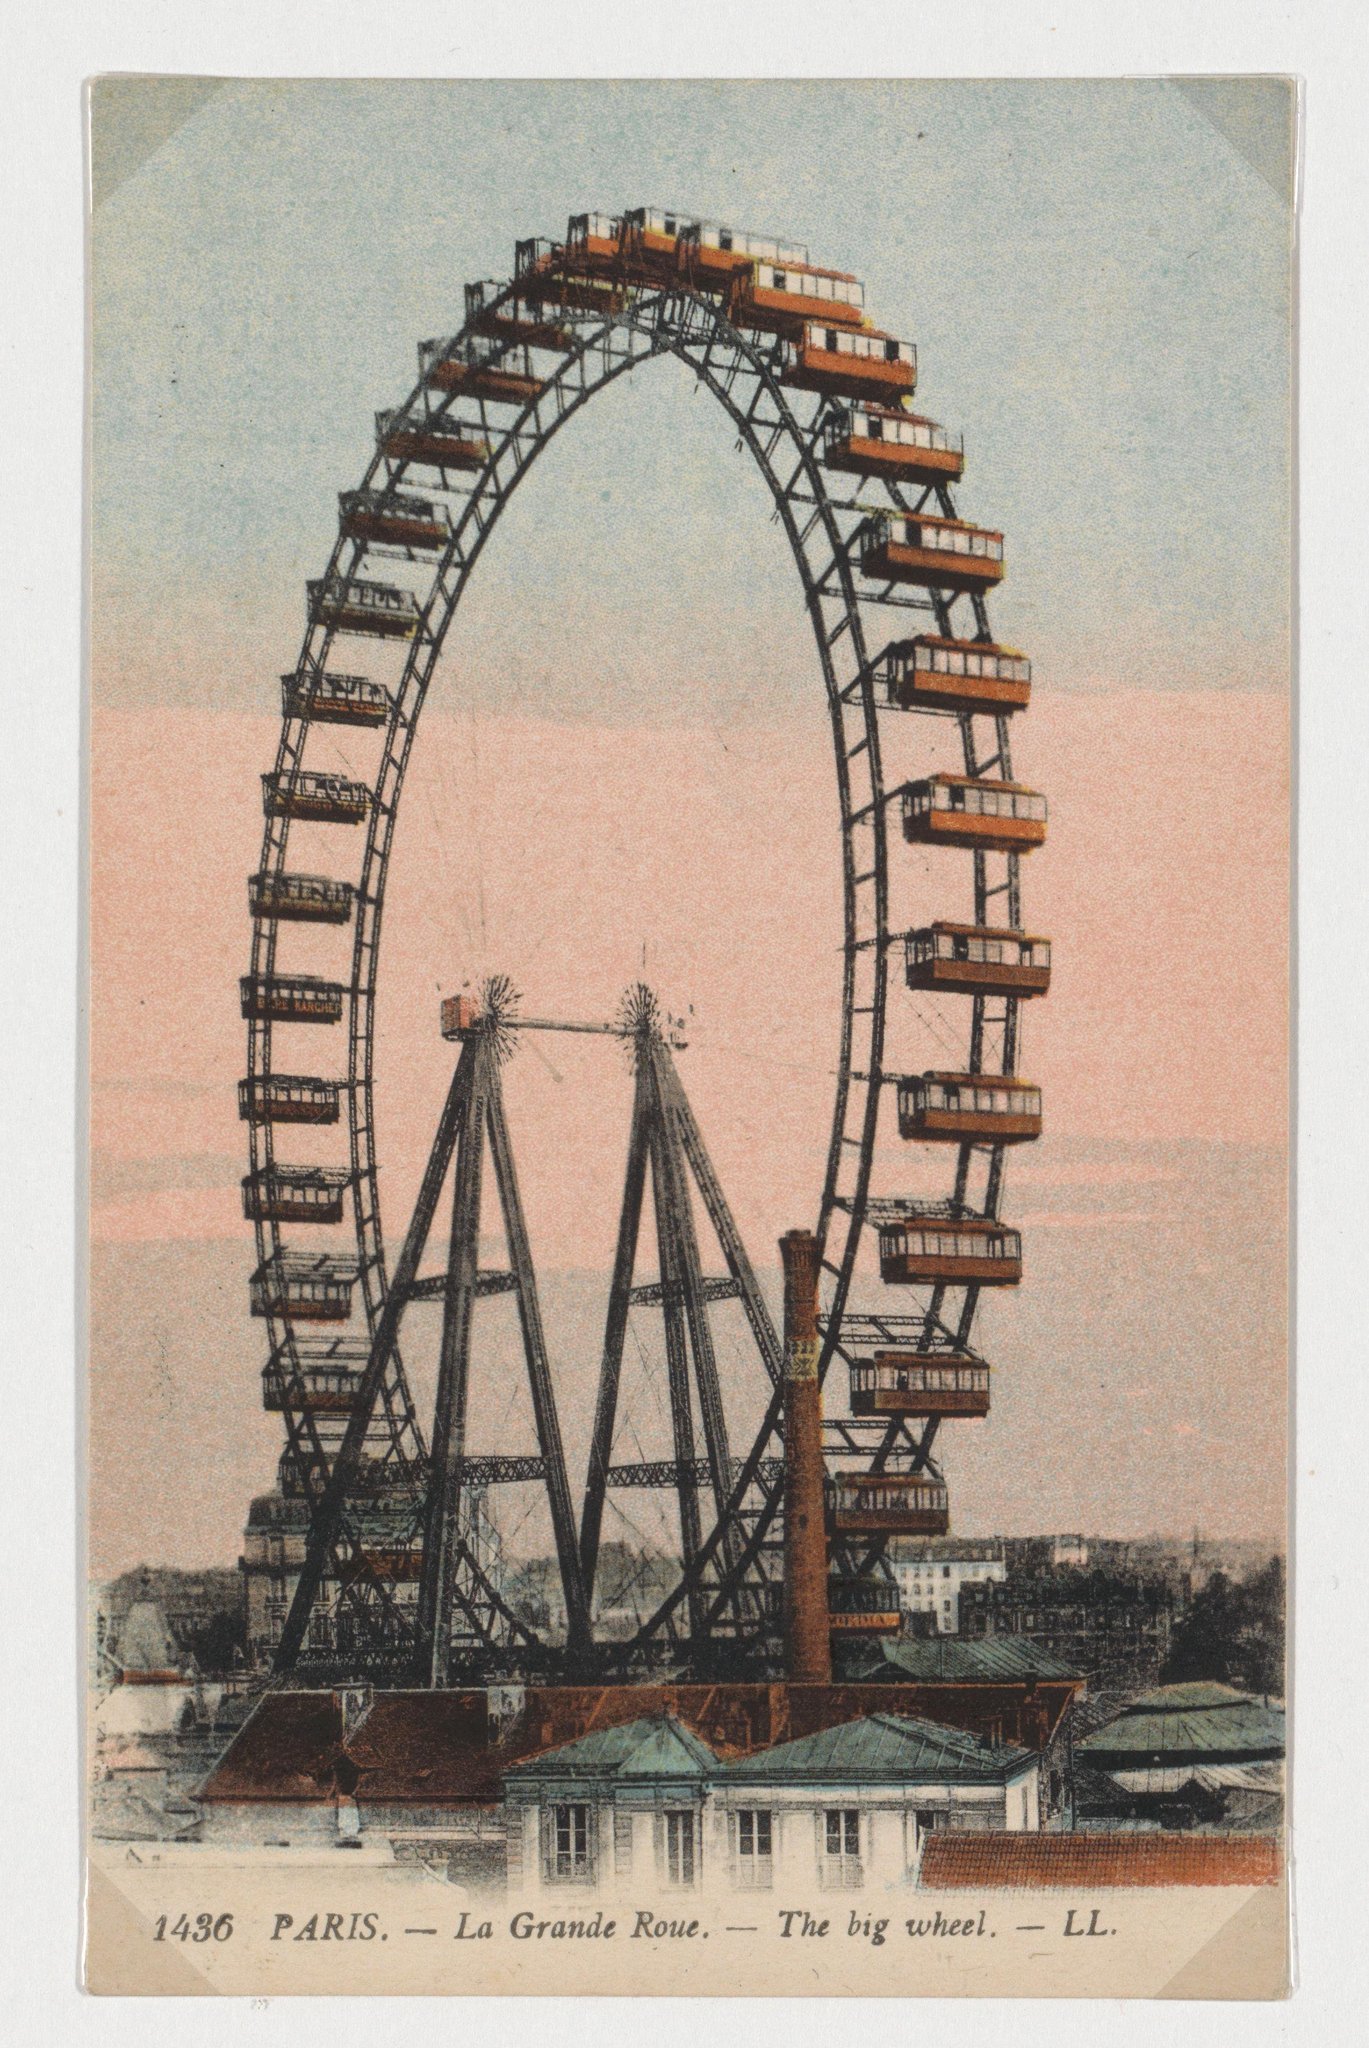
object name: photograph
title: Paris - La Grande Roue - The Big Wheel - LL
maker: ll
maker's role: fotograaf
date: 1919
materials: paper, photographic support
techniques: photograph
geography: paris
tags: giant wheel, ferris wheel, paris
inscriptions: number: ‘1436’, name: ‘Levy Fils [...] Cie. Paris’, date: ‘7 sept. 1919’, inscription: ‘[...]’